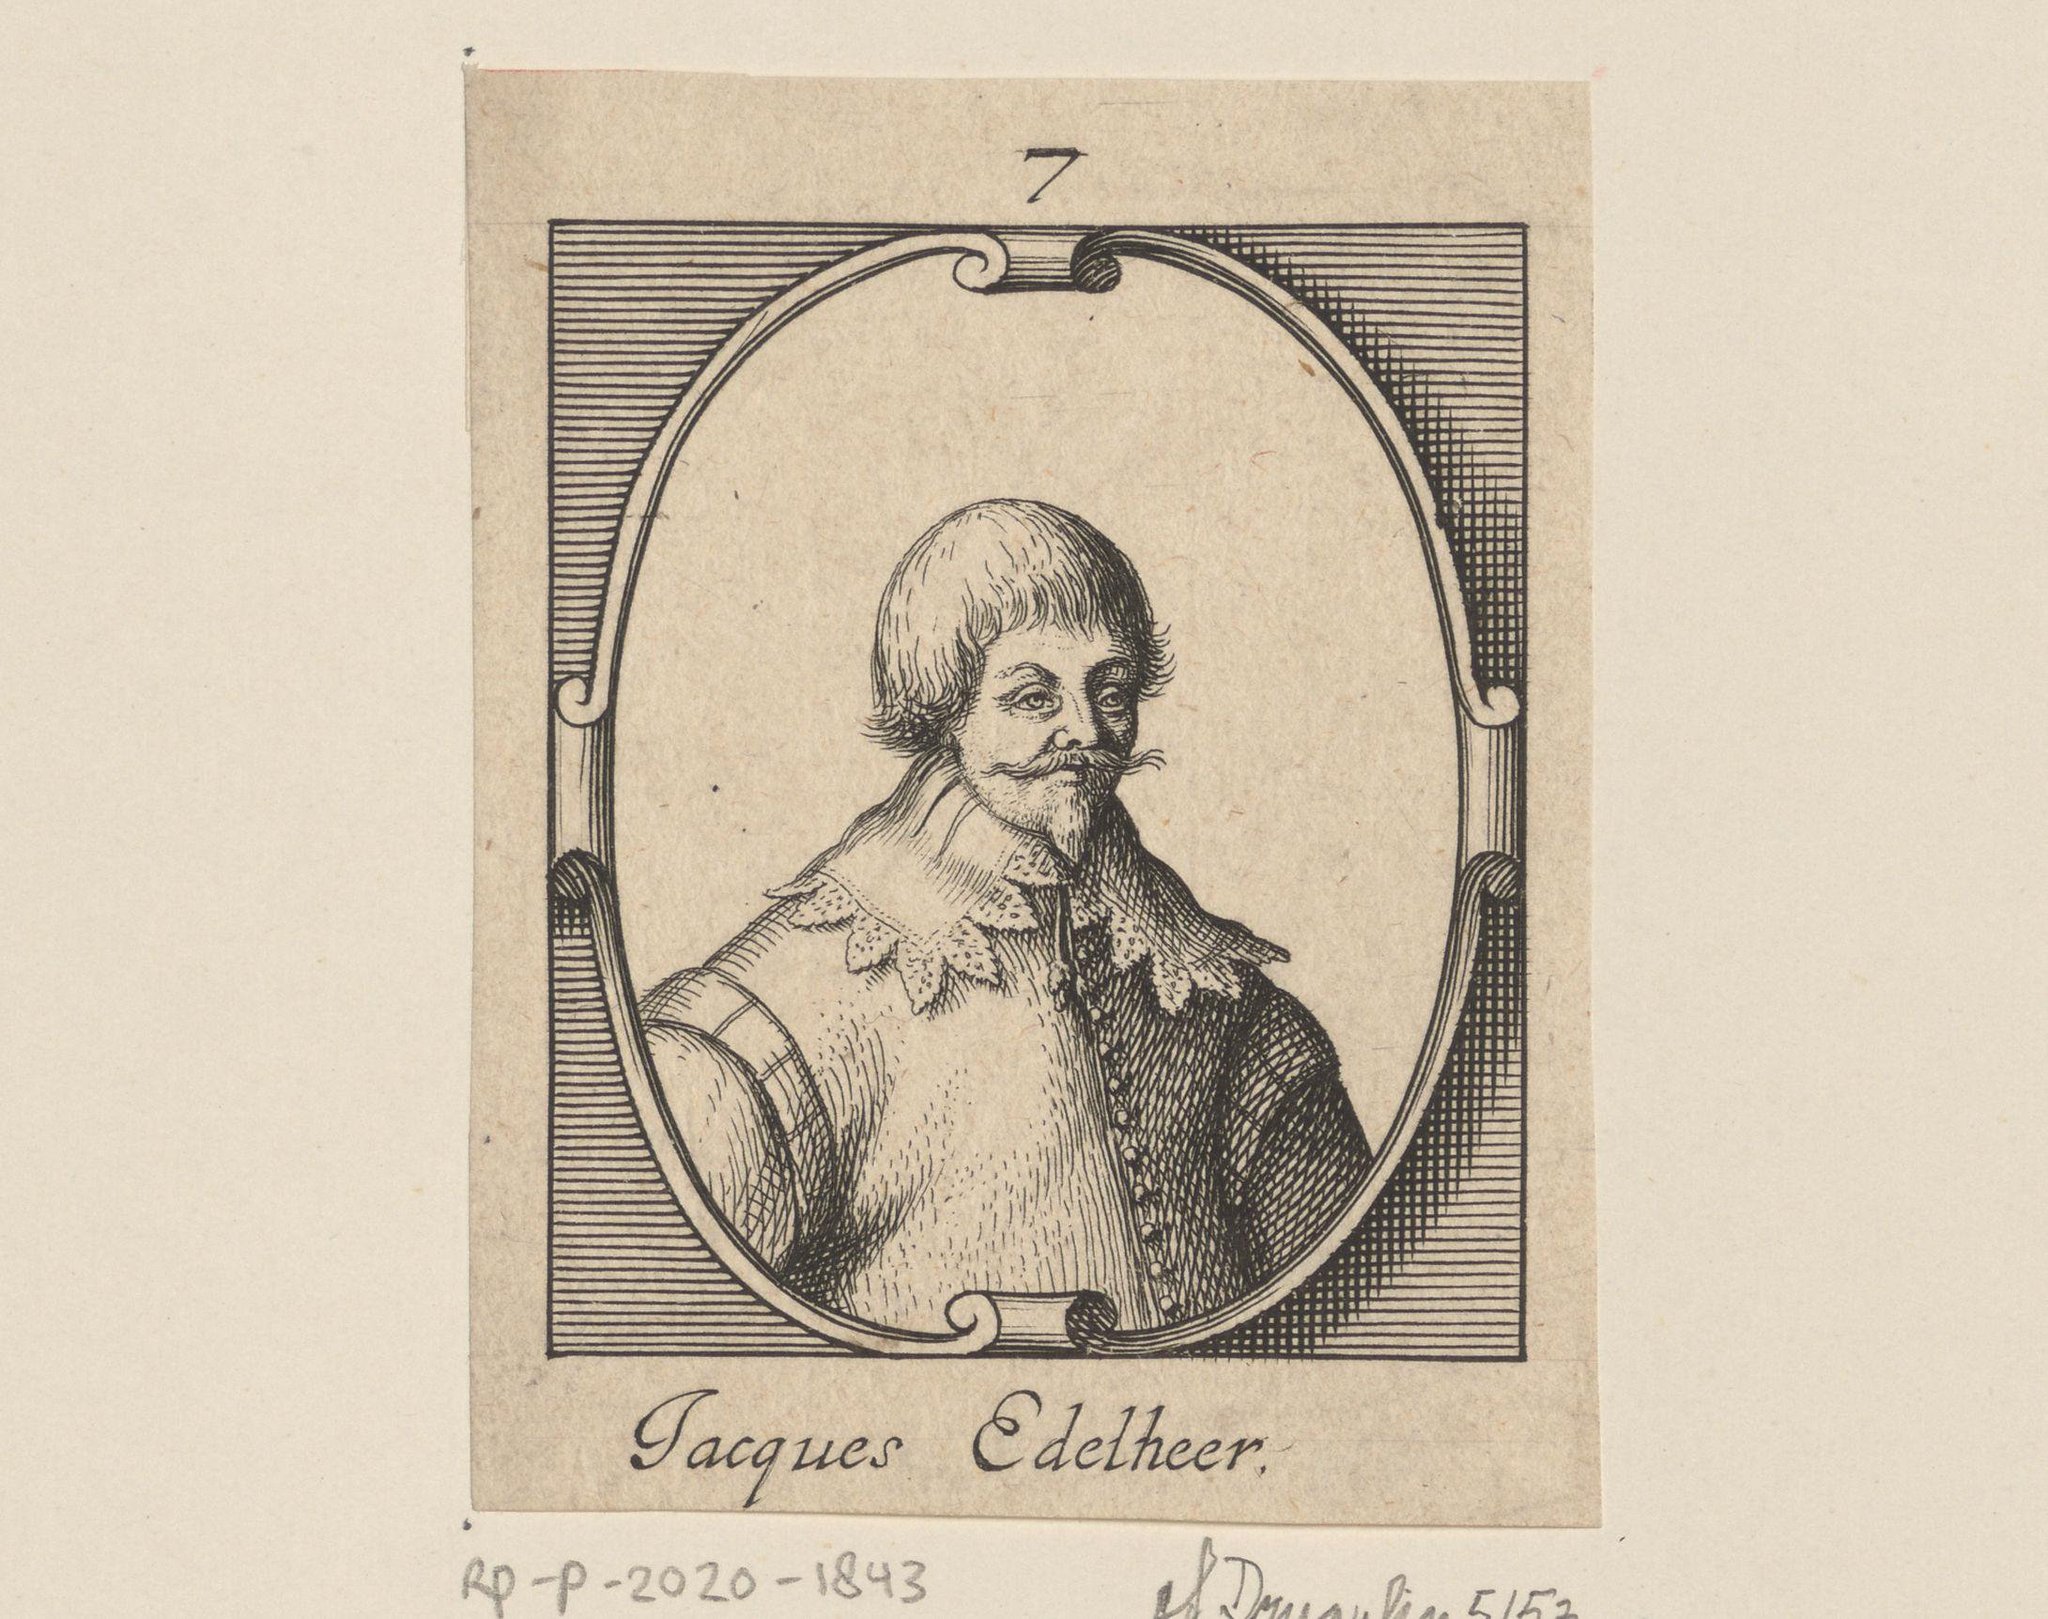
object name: print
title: Portret van Jacobus Edelheer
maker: Anonymous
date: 1632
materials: paper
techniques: engraving, etching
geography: northern netherlands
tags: louvain, politician, jacobus edelheer, historical persons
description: Prent is geknipt uit een blad met portretten van tien Brabantse afgevaardigden bij de vredesbesprekingen in 1632. Onder de portretten staat een tekst met als titel: Af-beeldinge van de Vrede-maeckers / Ofte Gedeputeerden uyt Brabant, gekomen in 'sGraven-Hage den 4. Decembris 1632.